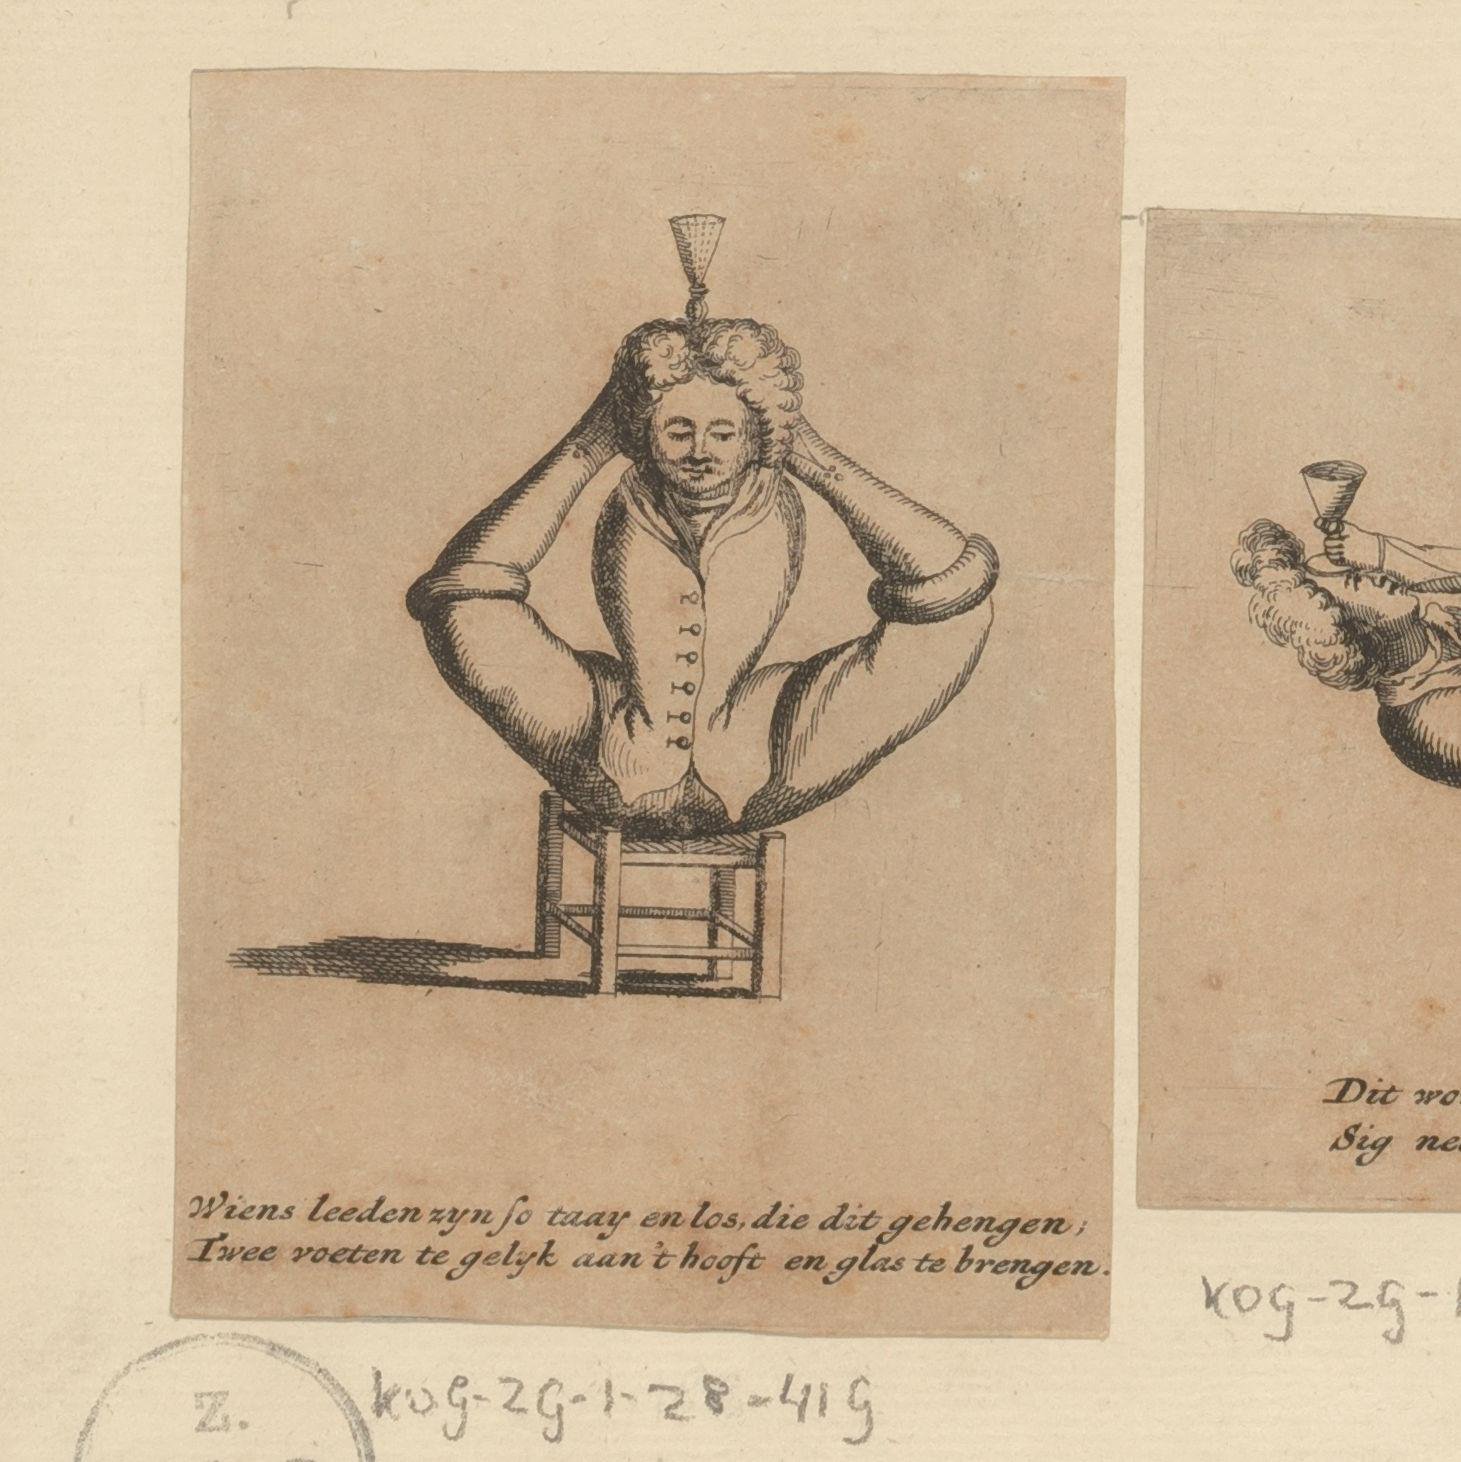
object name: print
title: Valerius, een man zonder armen raakt met zijn voeten zijn hoofd aan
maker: Anonymous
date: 1700-1749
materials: paper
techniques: engraving, etching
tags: acrobat ~ circus, human monstrosities ~ freak show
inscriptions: stamp, collector's mark: Lugt 1641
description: Valerius, een man zonder armen raakt met zijn voeten zijn hoofd aan waarop een glas staat. Onder de voorstelling een tweeregelig vers. Onderwerpsrubrieken binnen de Atlas Zeden en Gewoonten: Zeden en Gewoonten in Engeren Zin. Volksleven. Volksfeesten. Kermistypen, wondermenschen en dergelijken.